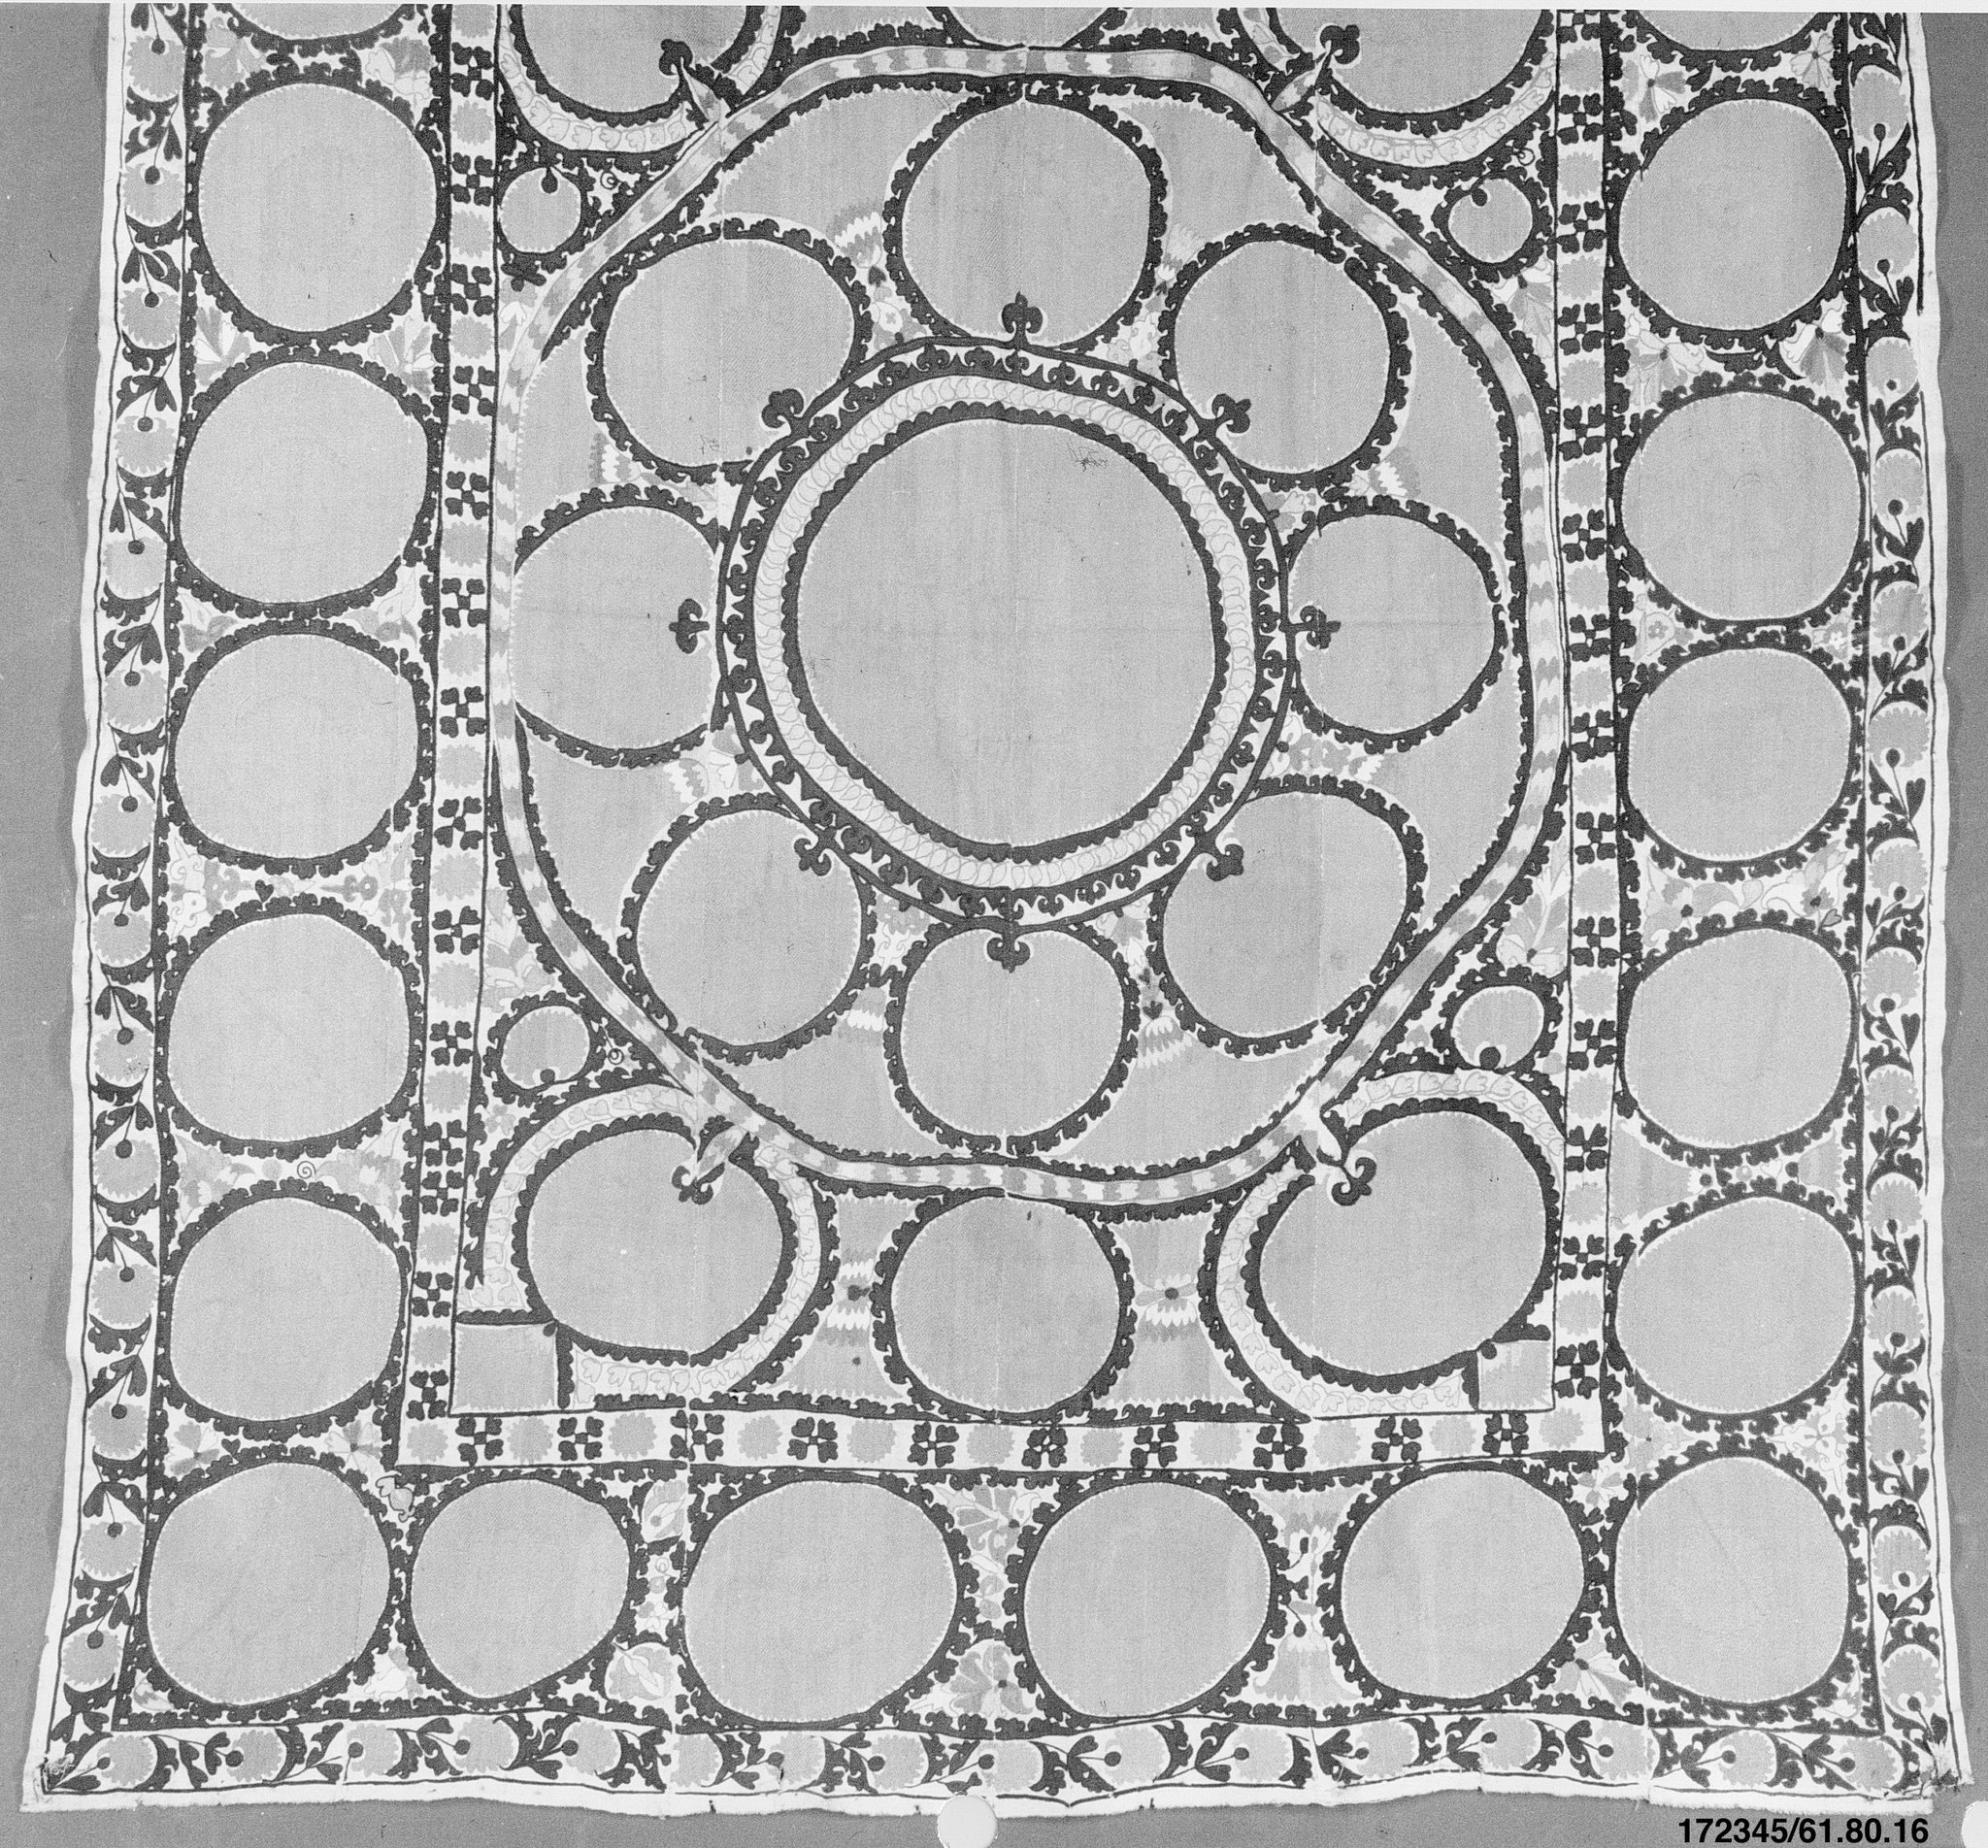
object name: hanging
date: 1701-1900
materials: linen, silk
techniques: embroidery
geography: uzbekistan